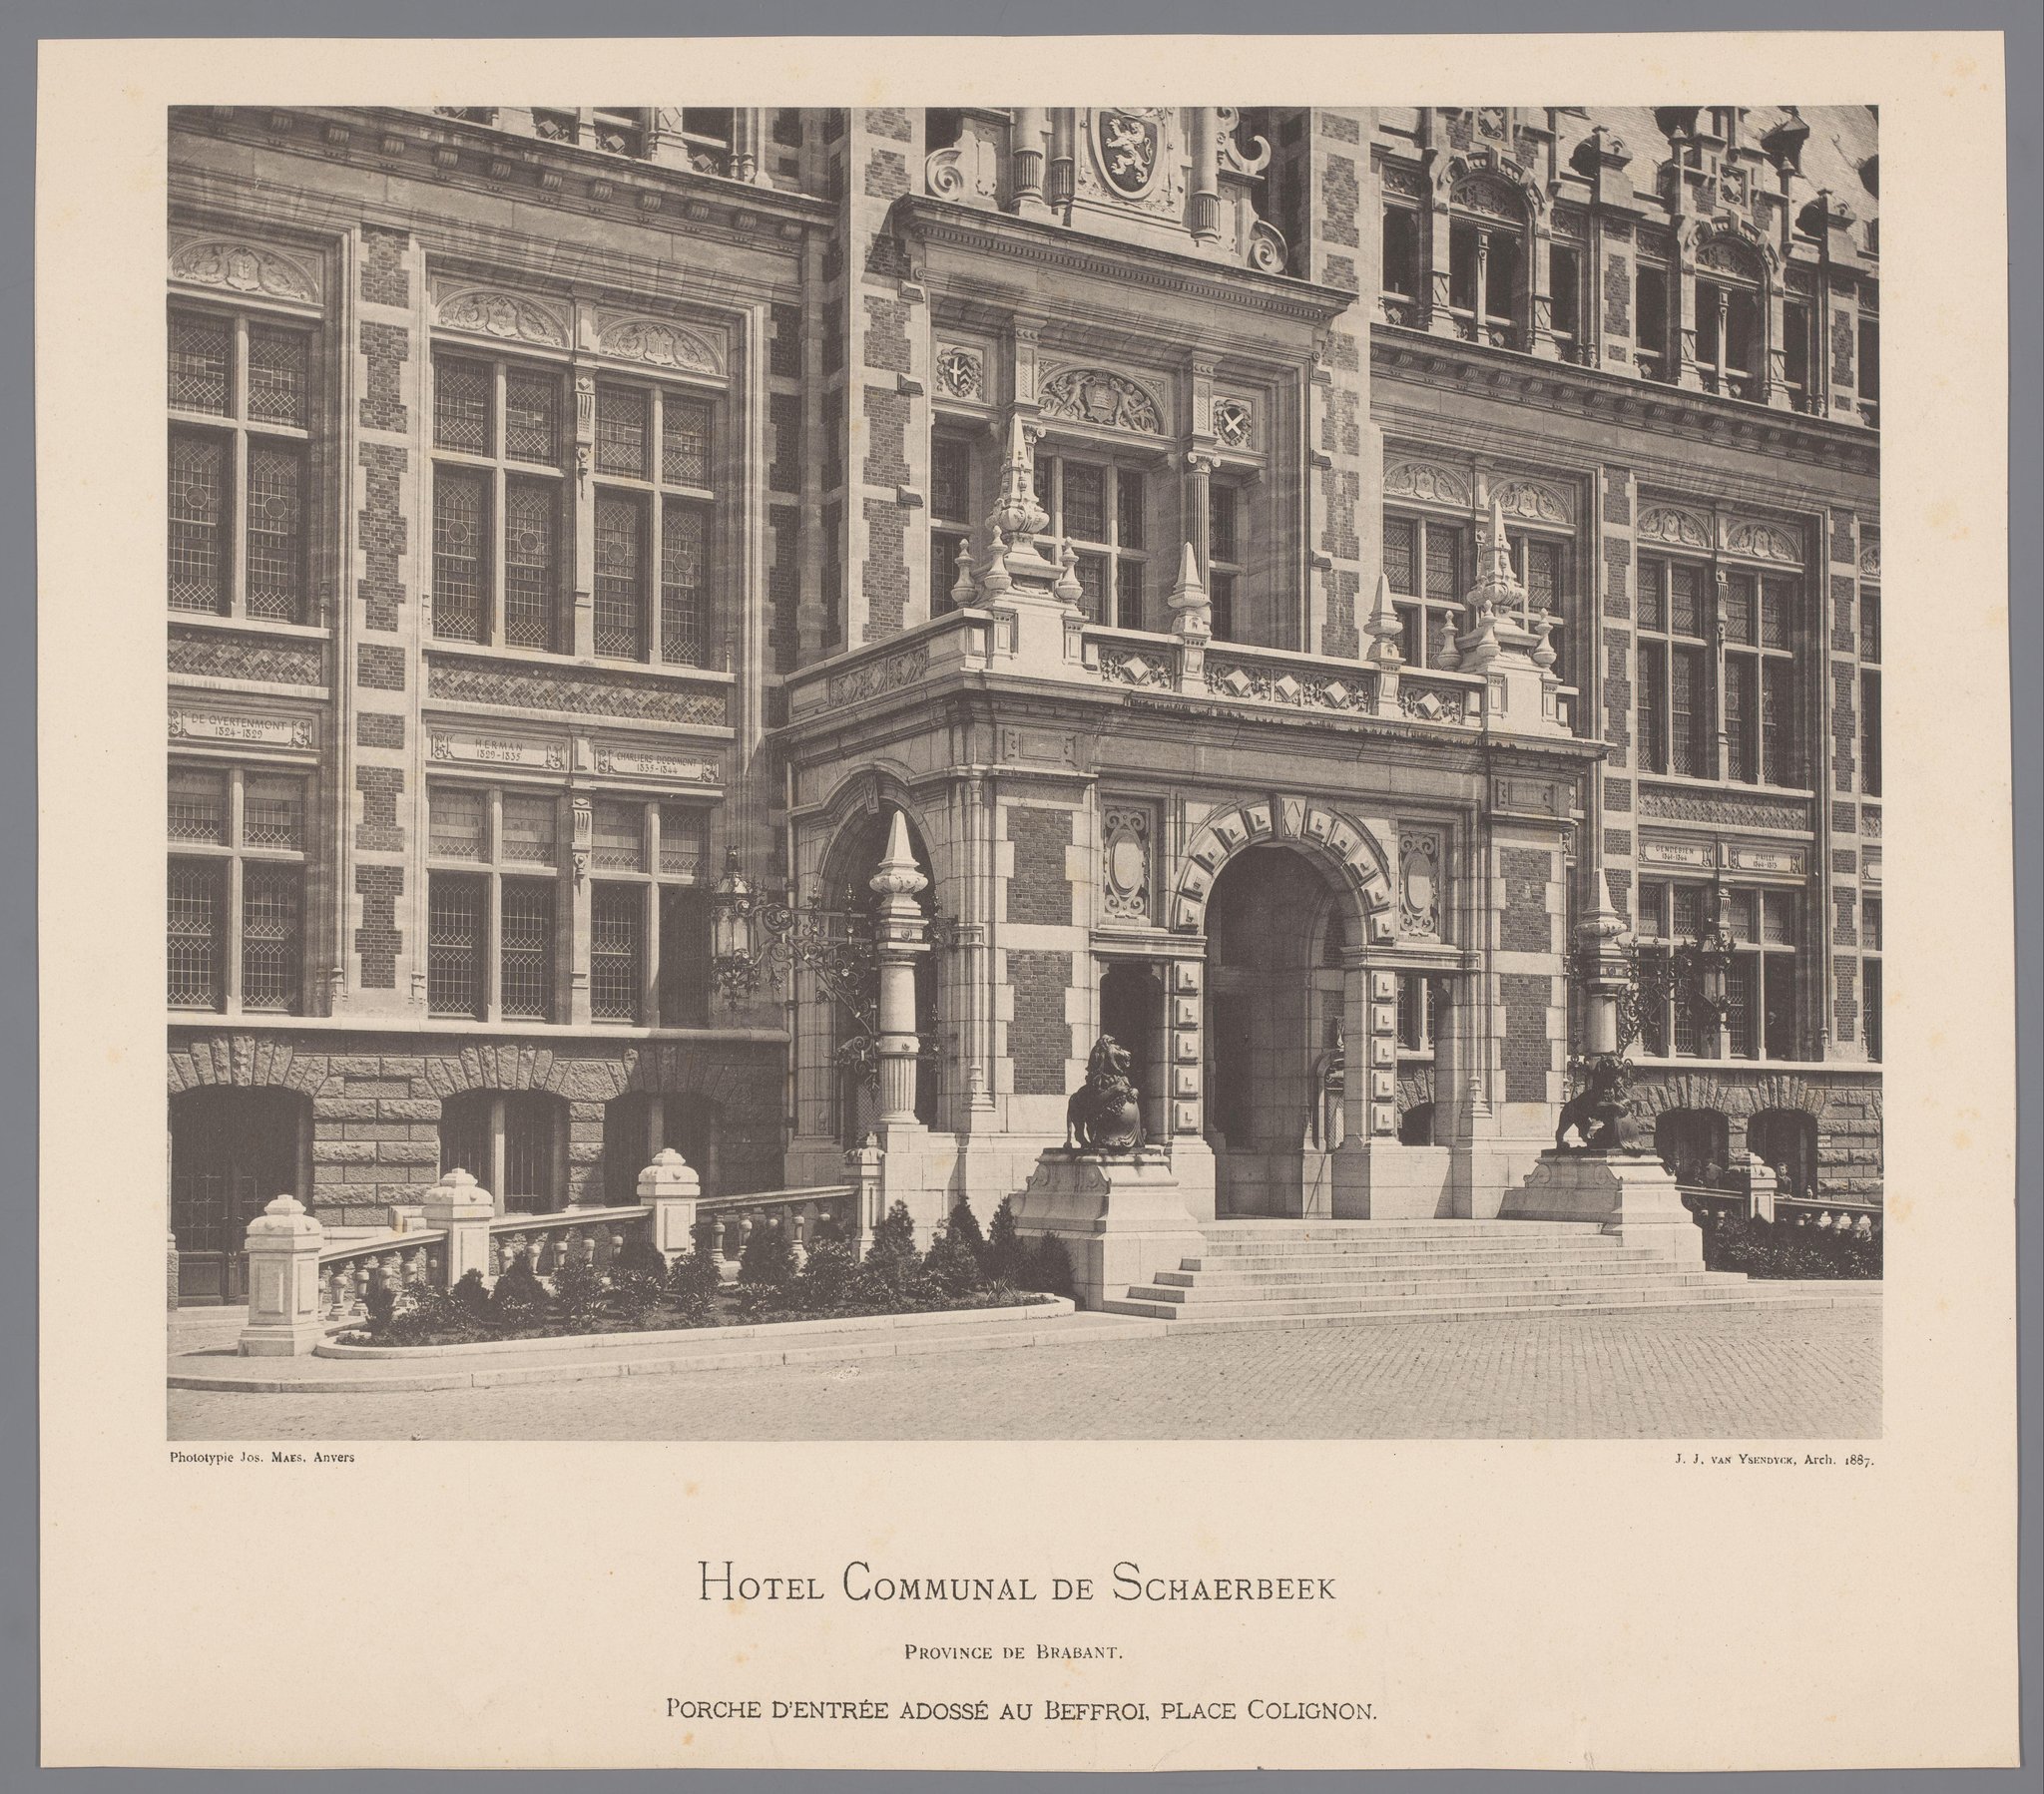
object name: photomechanical print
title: Detail van het stadhuis van Schaarbeek, België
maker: joseph maes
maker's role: fotograaf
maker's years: 1838-1908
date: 1887-1908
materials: paper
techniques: photograph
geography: antwerp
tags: townhall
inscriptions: inscription: ‘J. J. VAN YSENDYCK, Arch. 1887.’